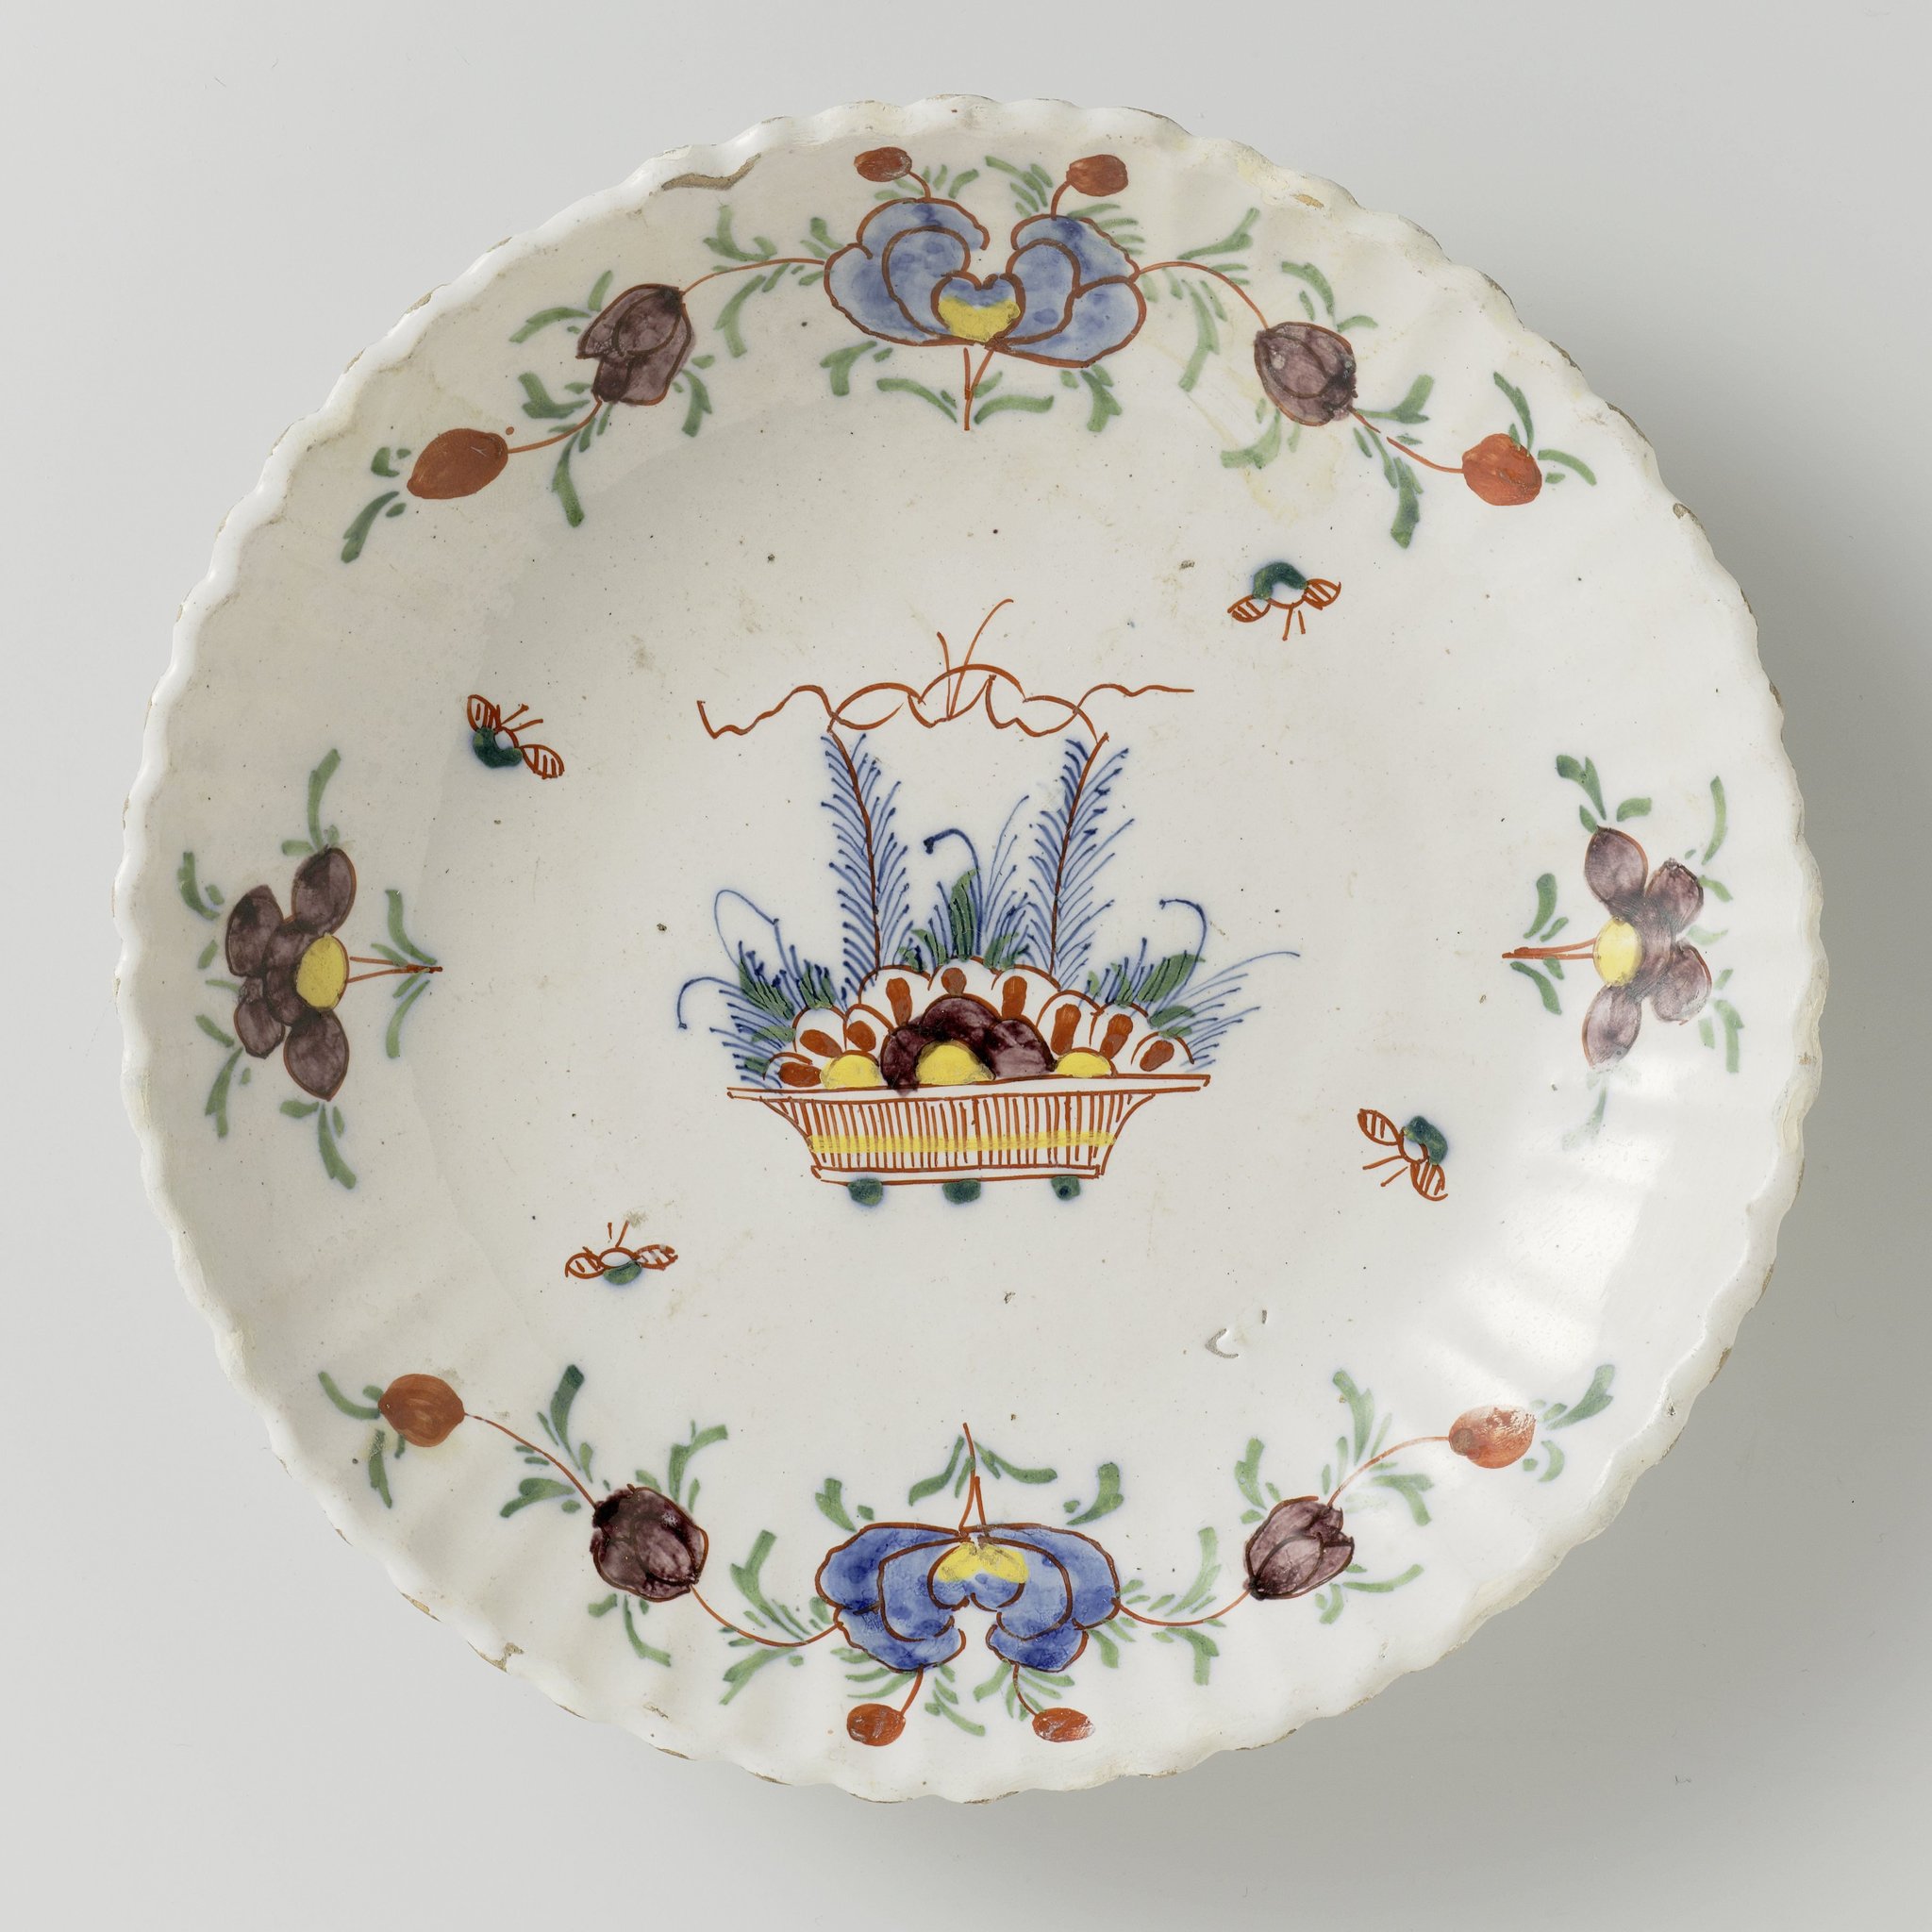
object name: platter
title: Schotel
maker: Anonymous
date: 1740-1775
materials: faience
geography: delft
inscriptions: mark: ‘iets slingerende lijn’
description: Schoteltje van faience. Veelkleurig beschilderd met een mand en bloemdecoraties.